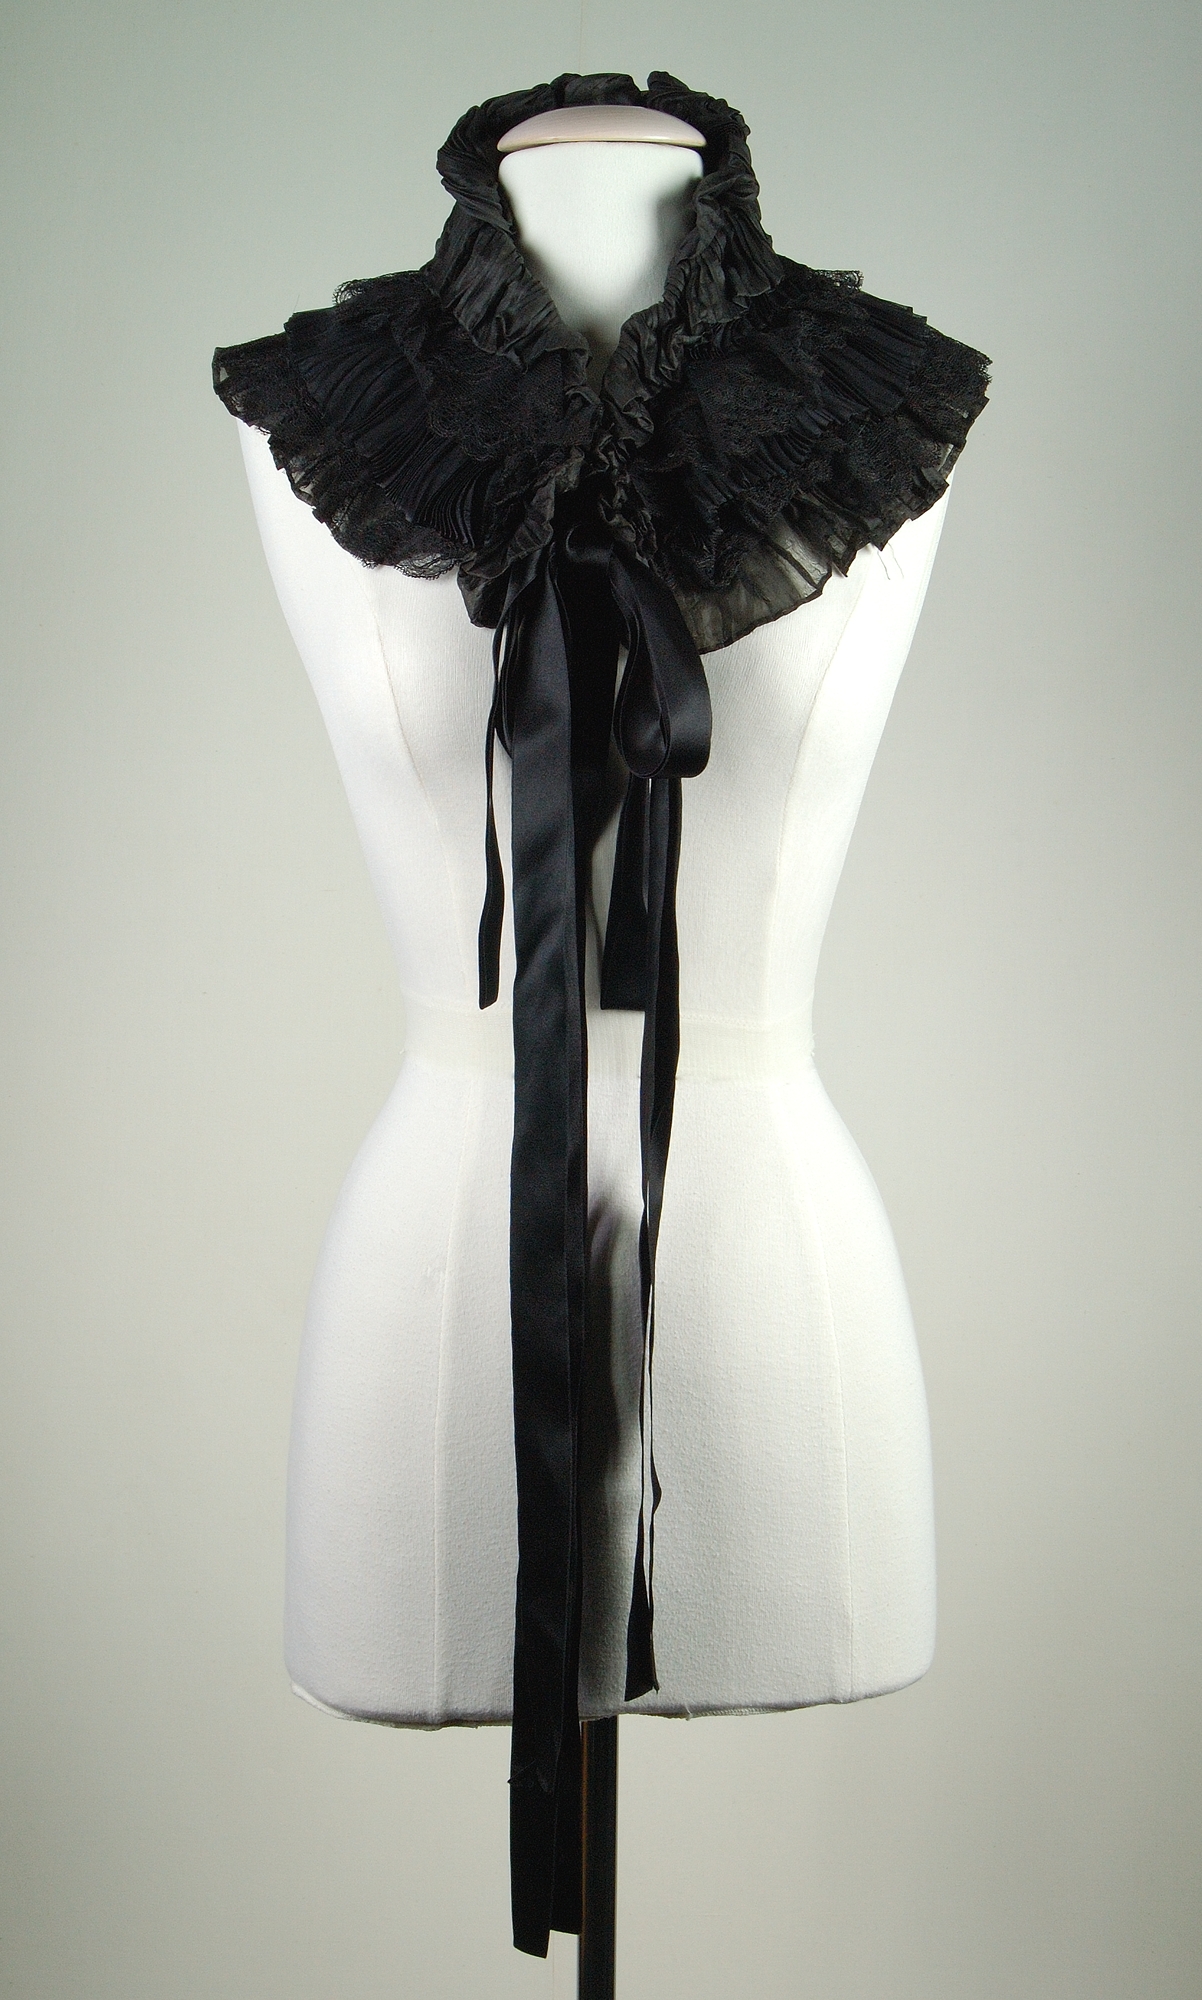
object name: collar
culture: american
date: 1895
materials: silk